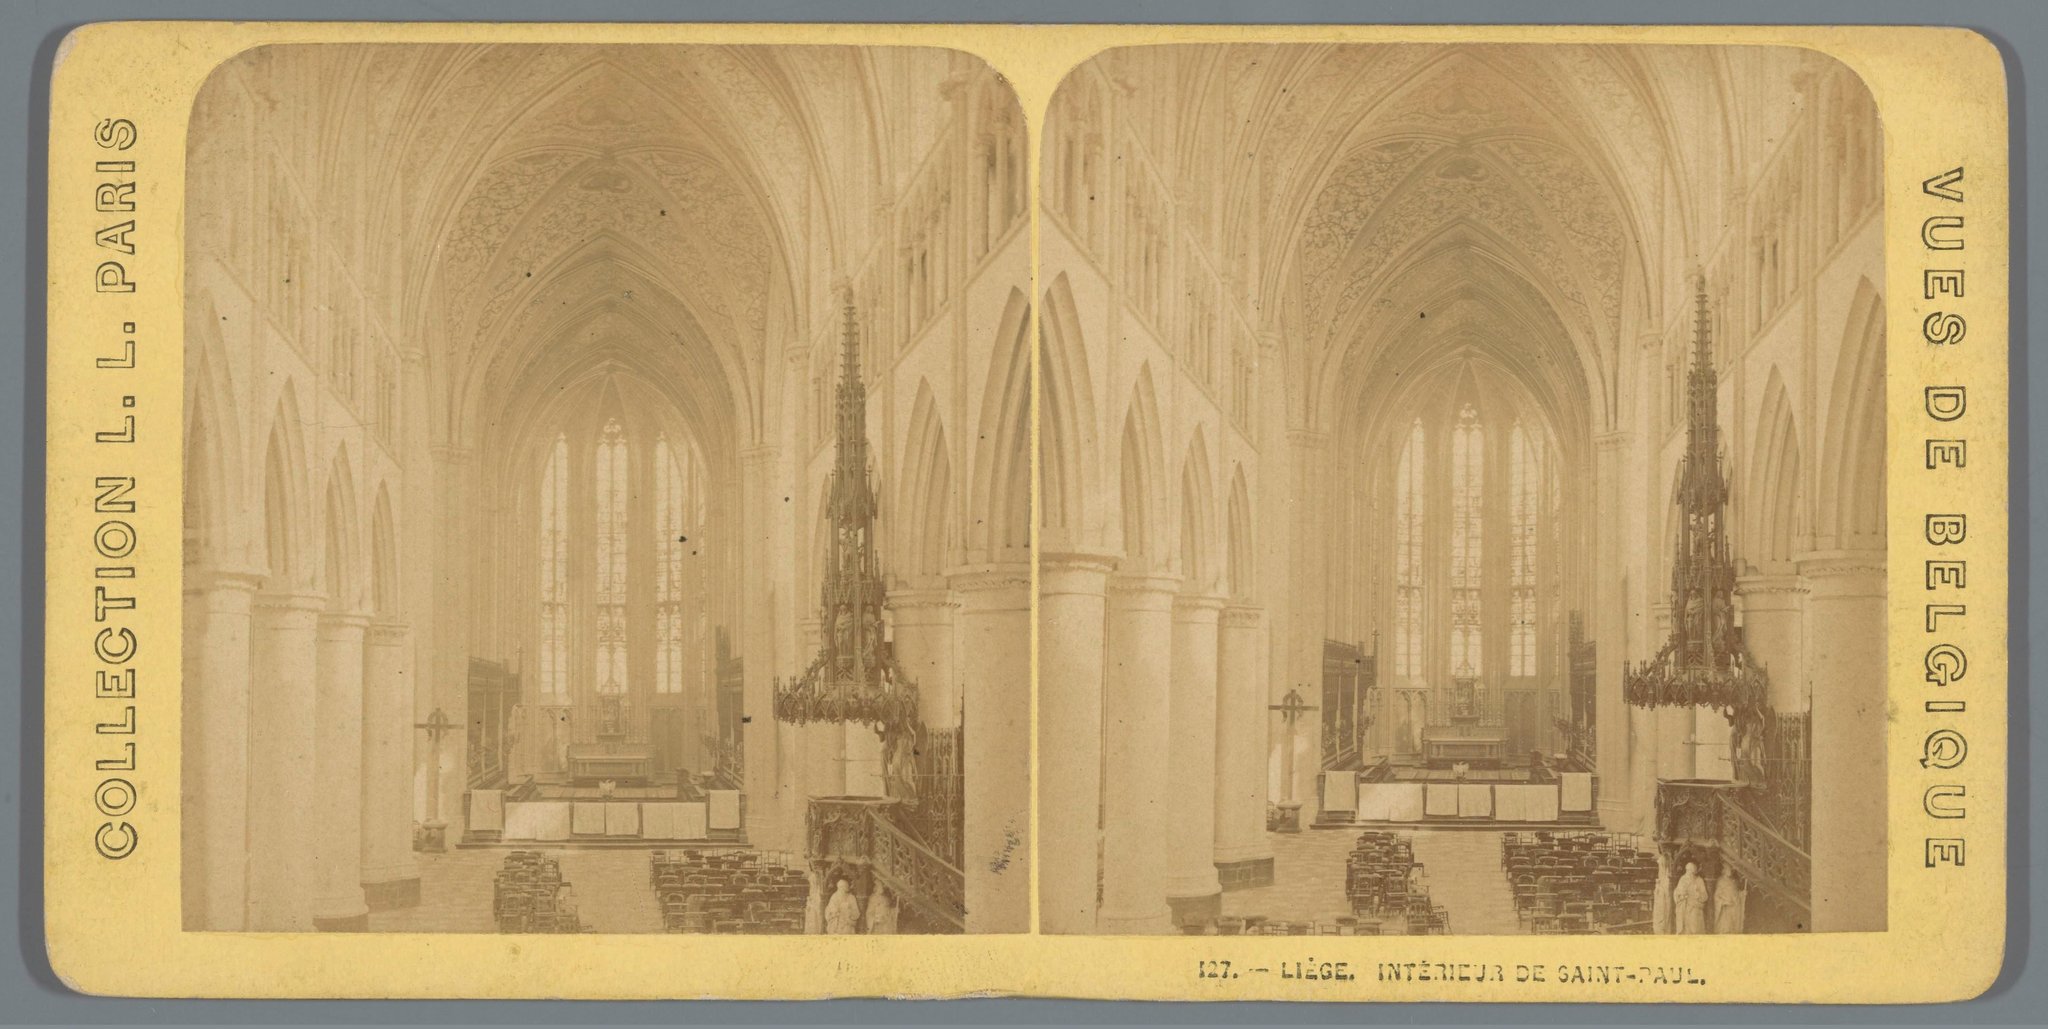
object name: stereograph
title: Liège. Intérieur de Saint-Paul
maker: Anonymous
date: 1873-1890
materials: cardboard, paper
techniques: albumen print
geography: liège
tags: interior of church, pulpit, ambo, chancel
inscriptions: number: ‘127.’